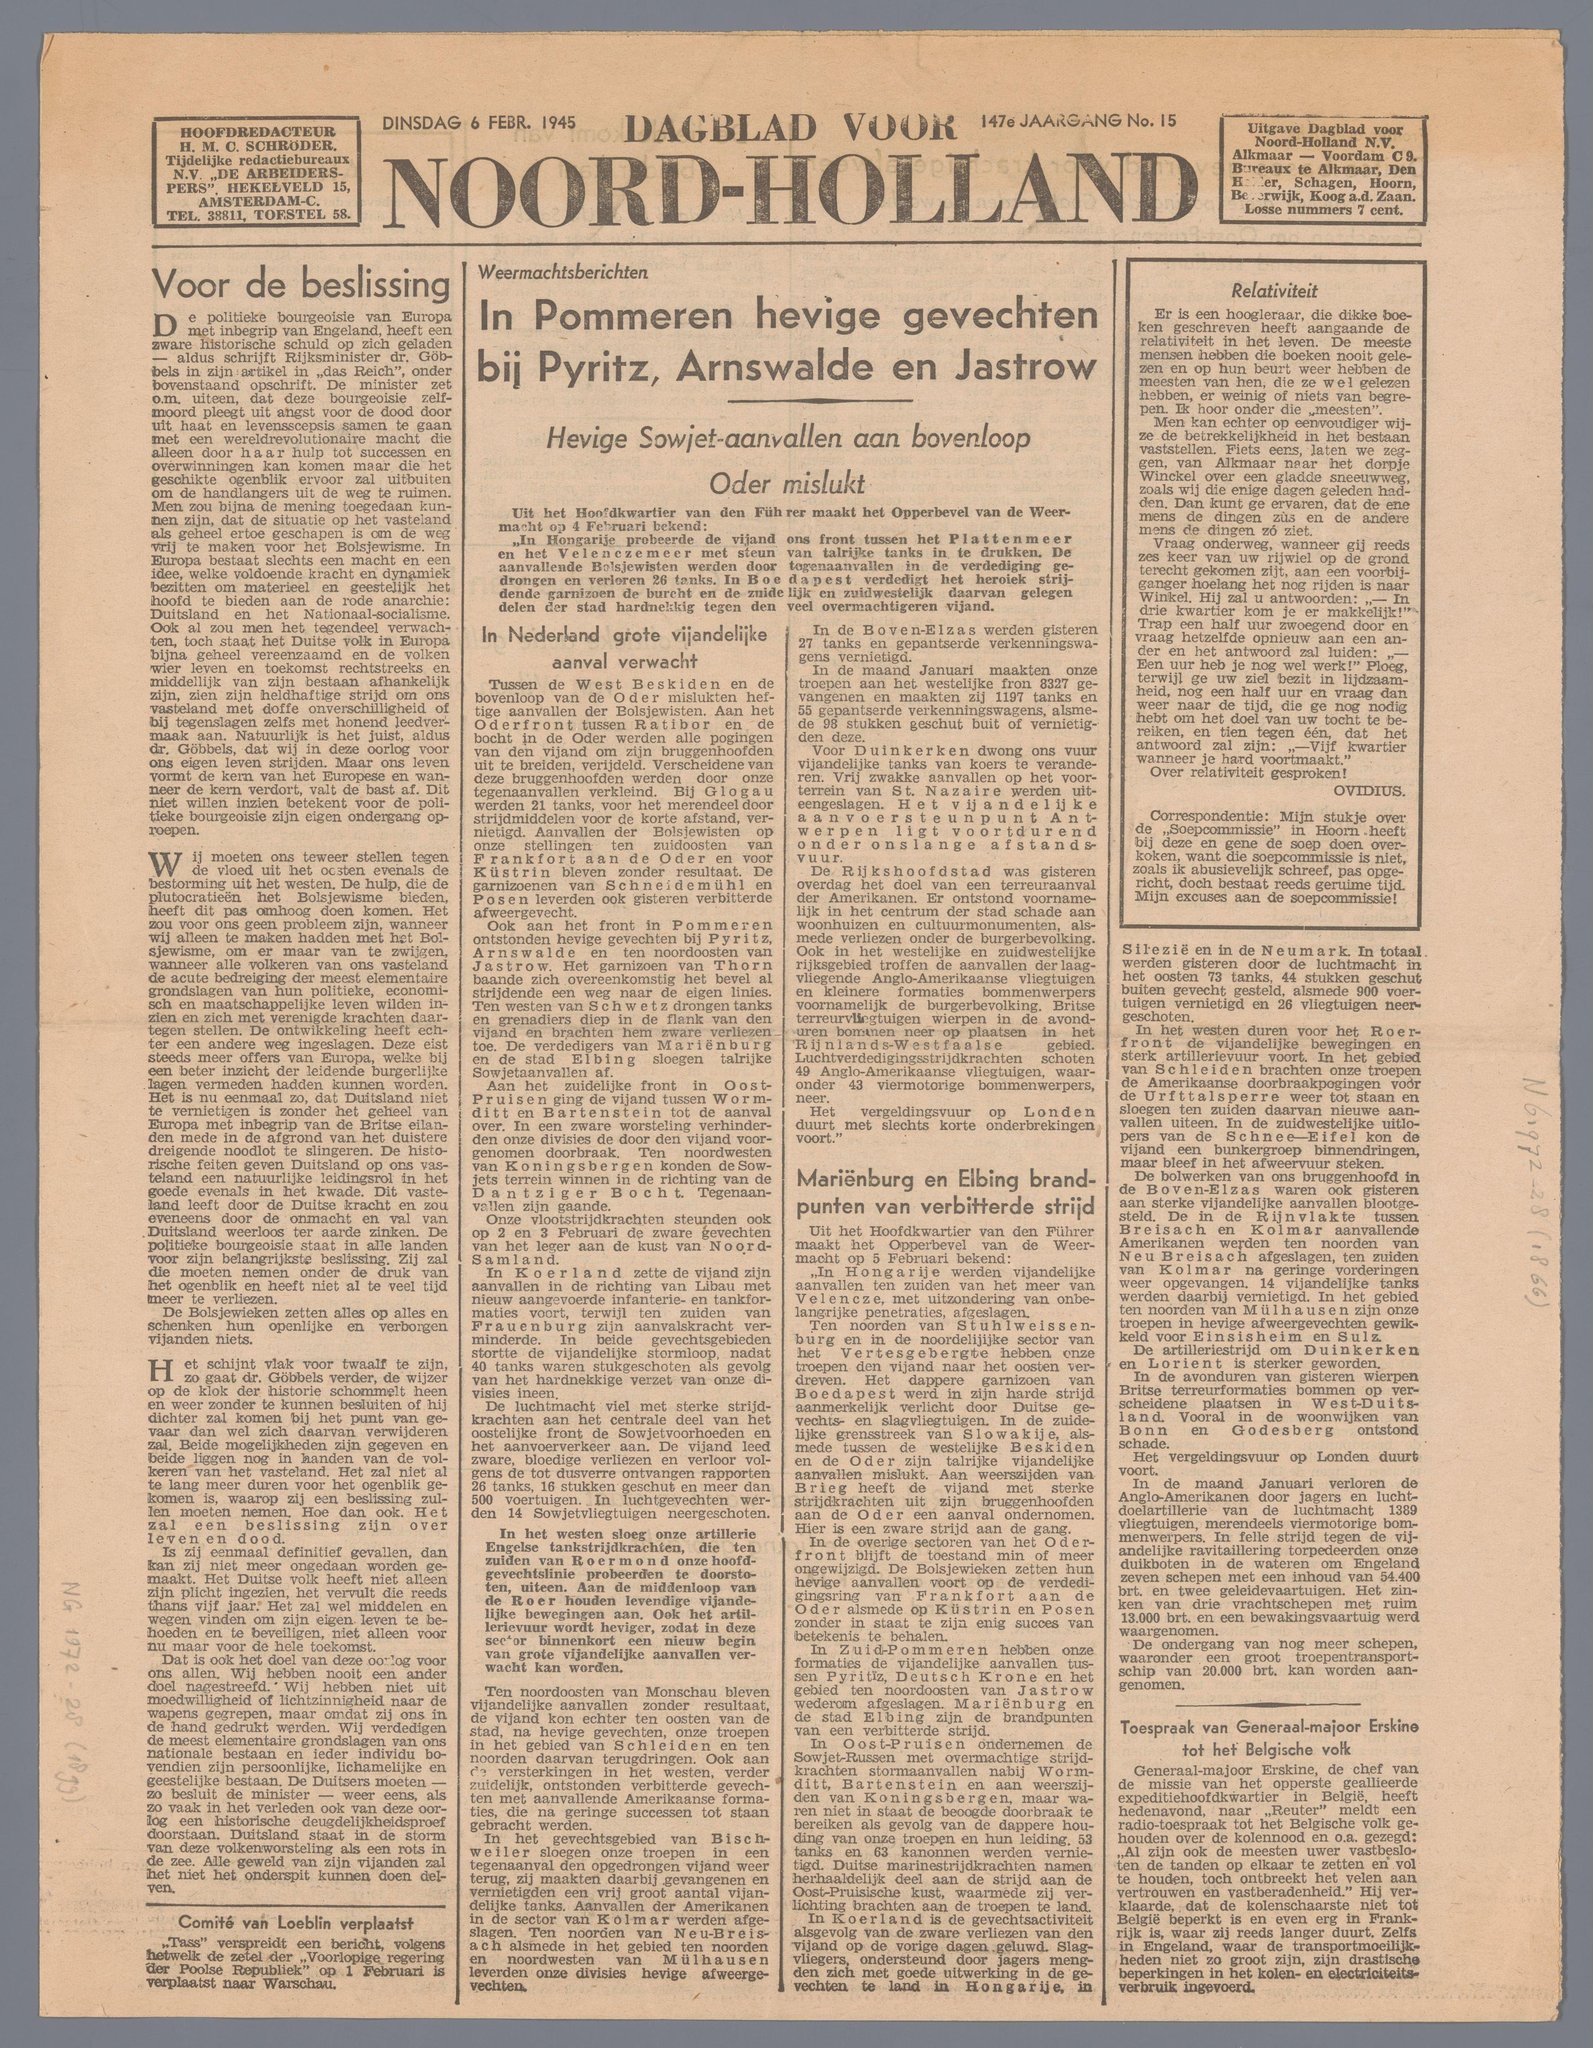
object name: newspaper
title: Dagblad voor Noord-Holland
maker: h.m.c. schröder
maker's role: redacteur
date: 1945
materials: paper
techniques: printing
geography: amsterdam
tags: europe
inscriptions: date